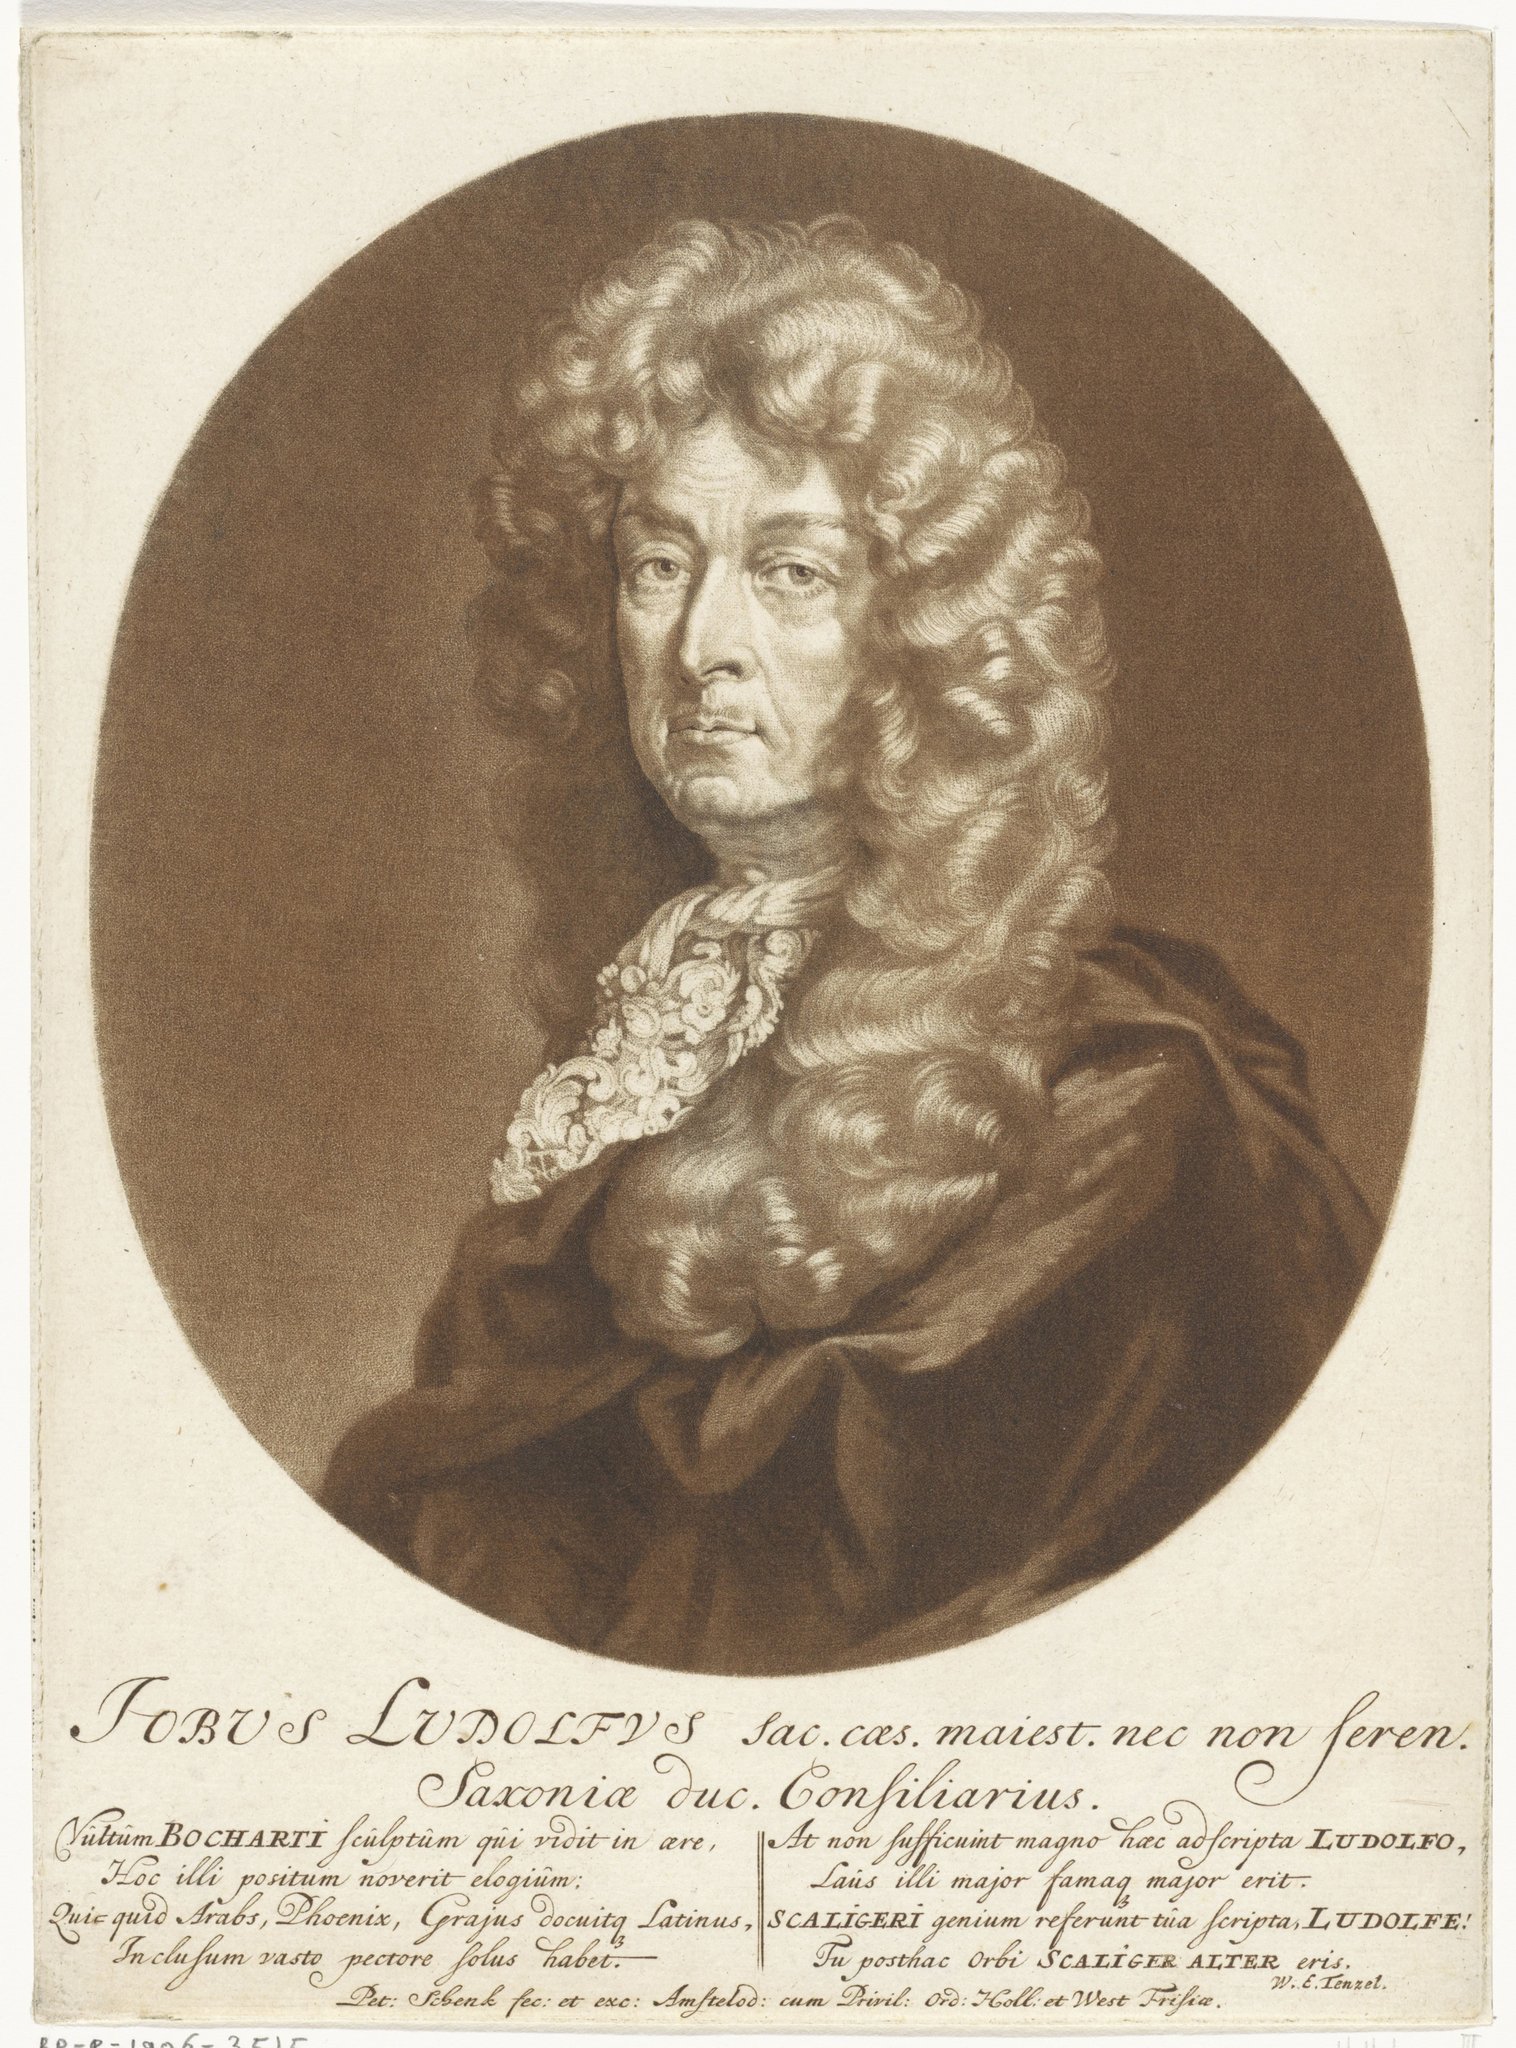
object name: print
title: Portret van Job Ludolf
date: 1670-1713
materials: paper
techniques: engraving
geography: amsterdam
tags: wig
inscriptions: collector's mark: Lugt 2228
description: De oriëntalist Job Ludolf. Hij was vanaf 1652 tot 1678 in dienst van Ernst I van Saksen-Gotha. Hij draagt een lange krulpruik en een kraag van kant.